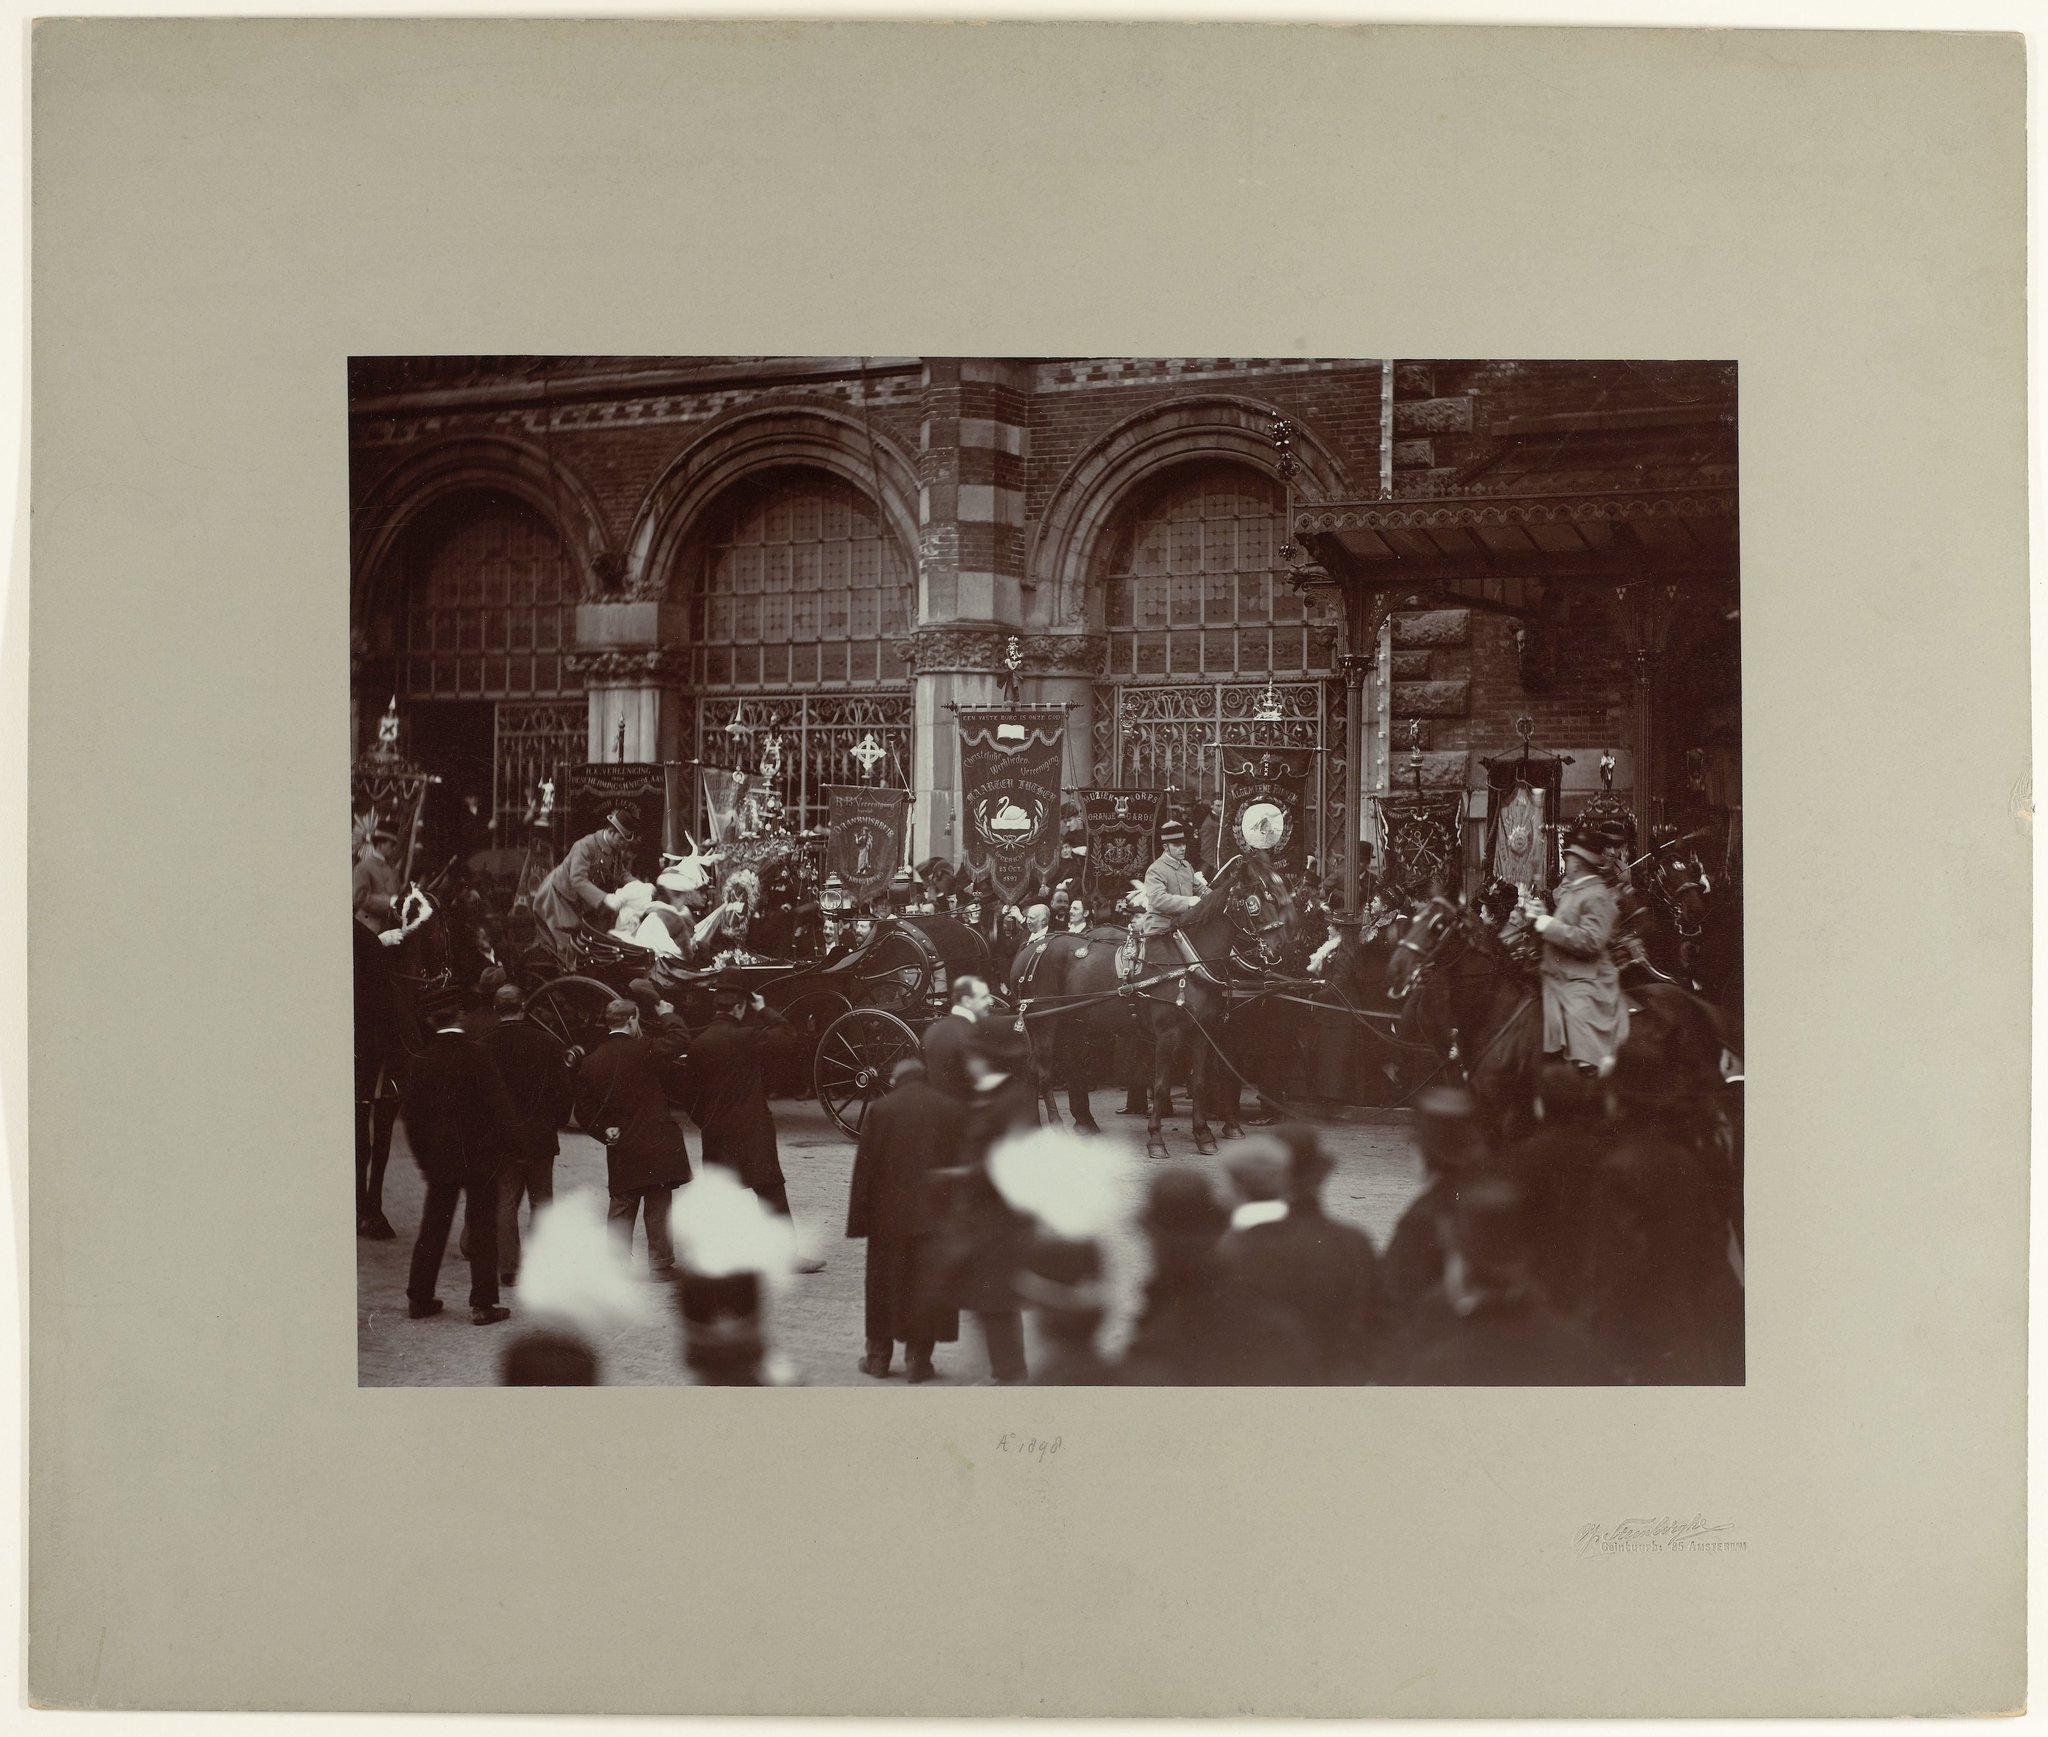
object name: photograph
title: Koningin Wilhelmina in een rijtuig voor het Rijksmuseum, op weg naar de troonsbestijging te Amsterdam in 1898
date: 1898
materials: cardboard, photographic support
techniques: collodion silver print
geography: amsterdam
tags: the hague, print maker, wilhelmina of the netherlands, coronation of a ruler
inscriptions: date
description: Koningin Wilhelmina en haar echtgenoot in een rijtuig op weg naar de troonsbestijging op het moment dat zij langs het Rijksmuseum te Amsterdam rijdt in 1898. Lans de weg staan toeschouwers.